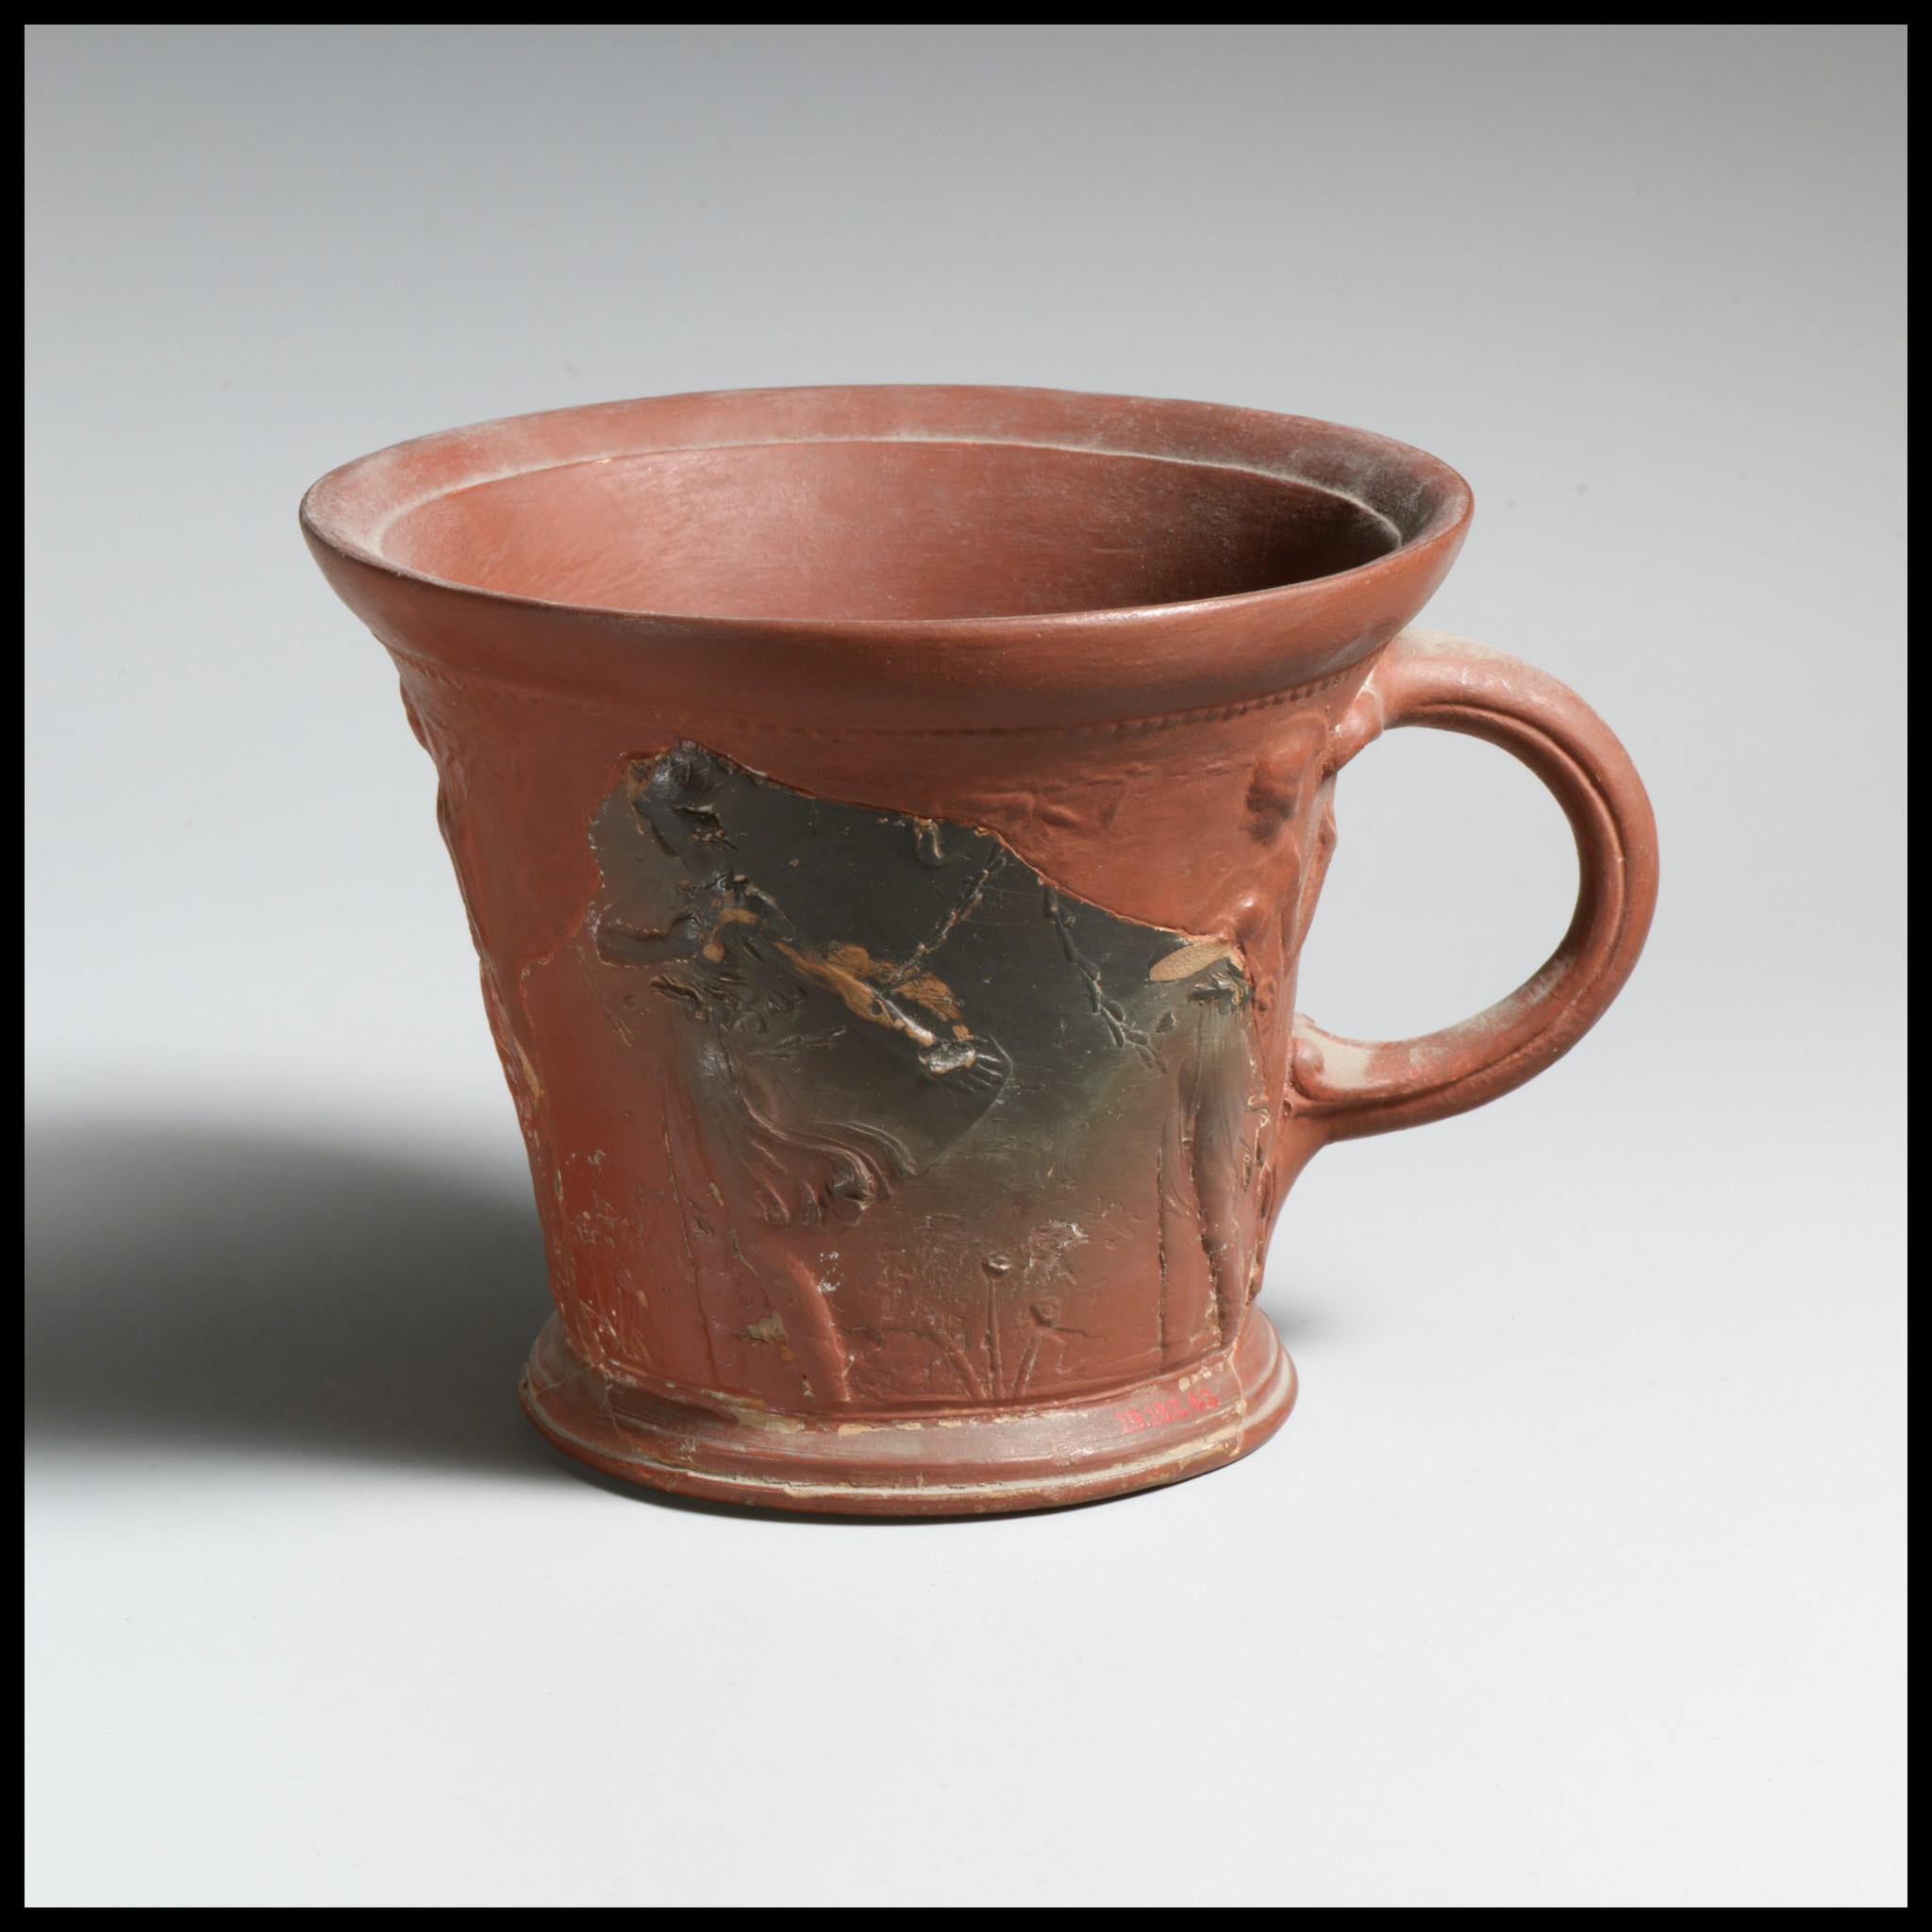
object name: cup, fragment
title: Terracotta cup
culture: roman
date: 100 BCE-100 CE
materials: terracotta